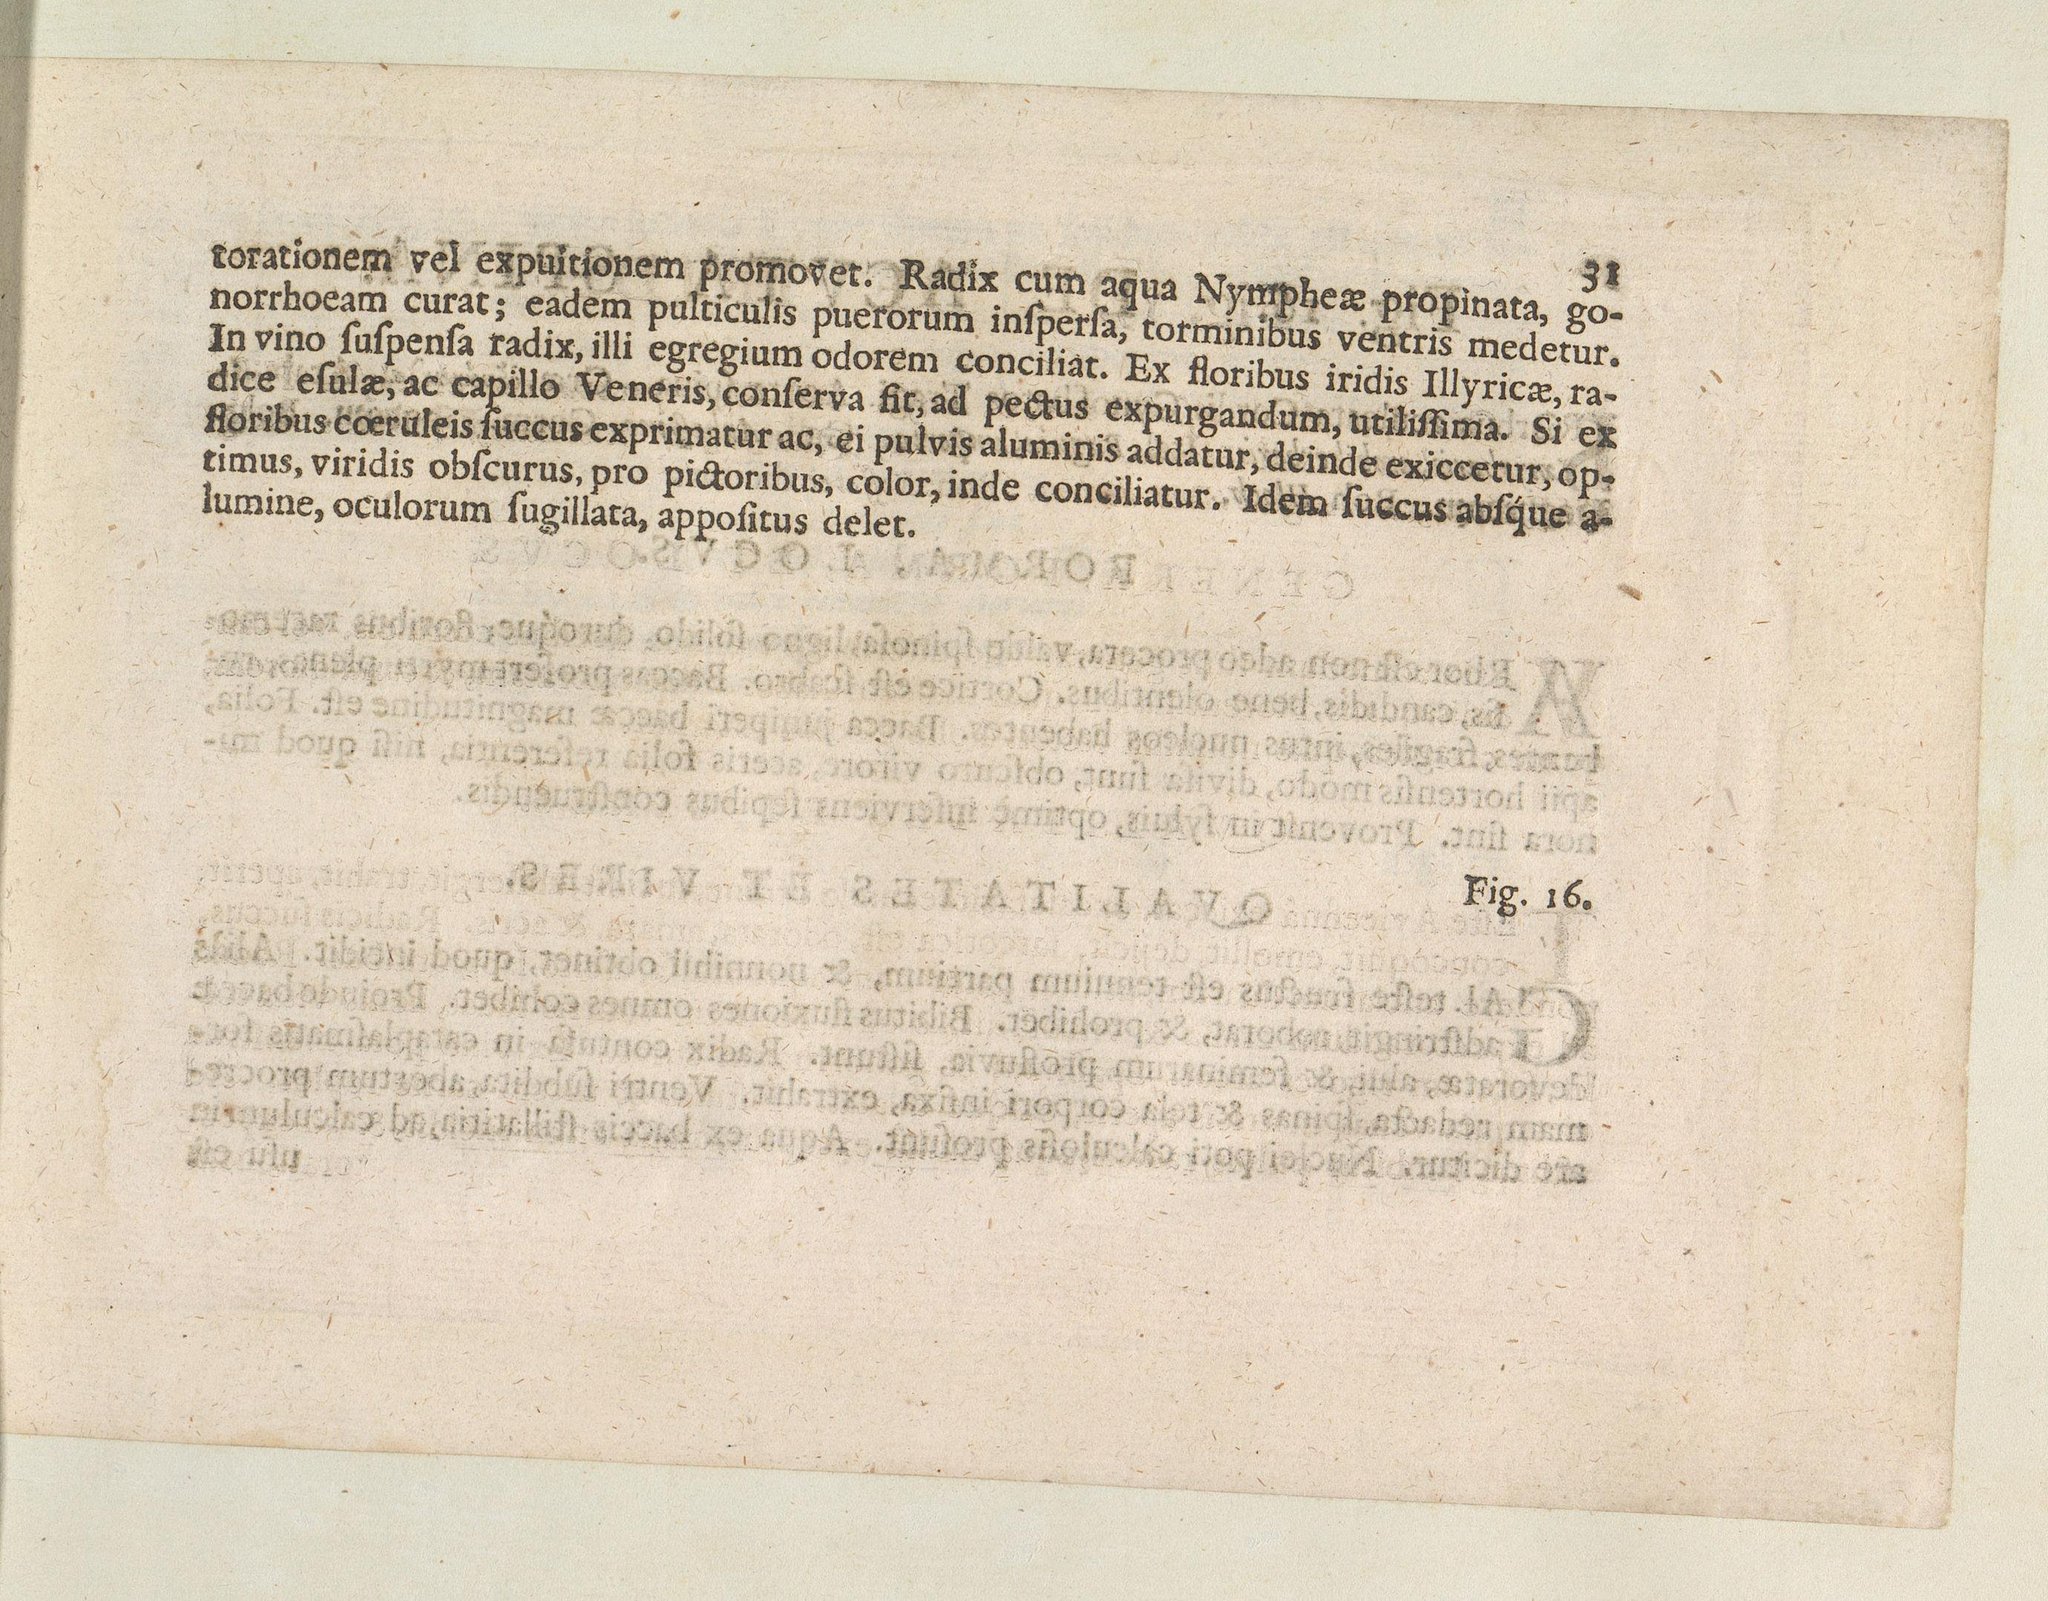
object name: text sheet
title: Fig. 15 'De Iride' in De Boodts herbarium van 1640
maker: anselmus boëtius de boodt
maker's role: draughtsman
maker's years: 1550-1632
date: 1640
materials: ink, paper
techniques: letterpress printing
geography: bruges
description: Beschrijving bij Fig. 15 op p. 31 in: Anselmi Boëtii de Boot I.C. Brugensis & Rodolphi II. Imp. Roman. medici a cubiculis Florum, Herbarum, ac fructuum selectiorum icones, & vires pleraeque hactenus ignotæ. Onderdeel van het album met bladen en platen uit De Boodts herbarium van 1640. Het twaalfde van twaalf albums met aquarellen van dieren, vogels en planten bekend rond 1600, gemaakt in opdracht van keizer Rudolf II.